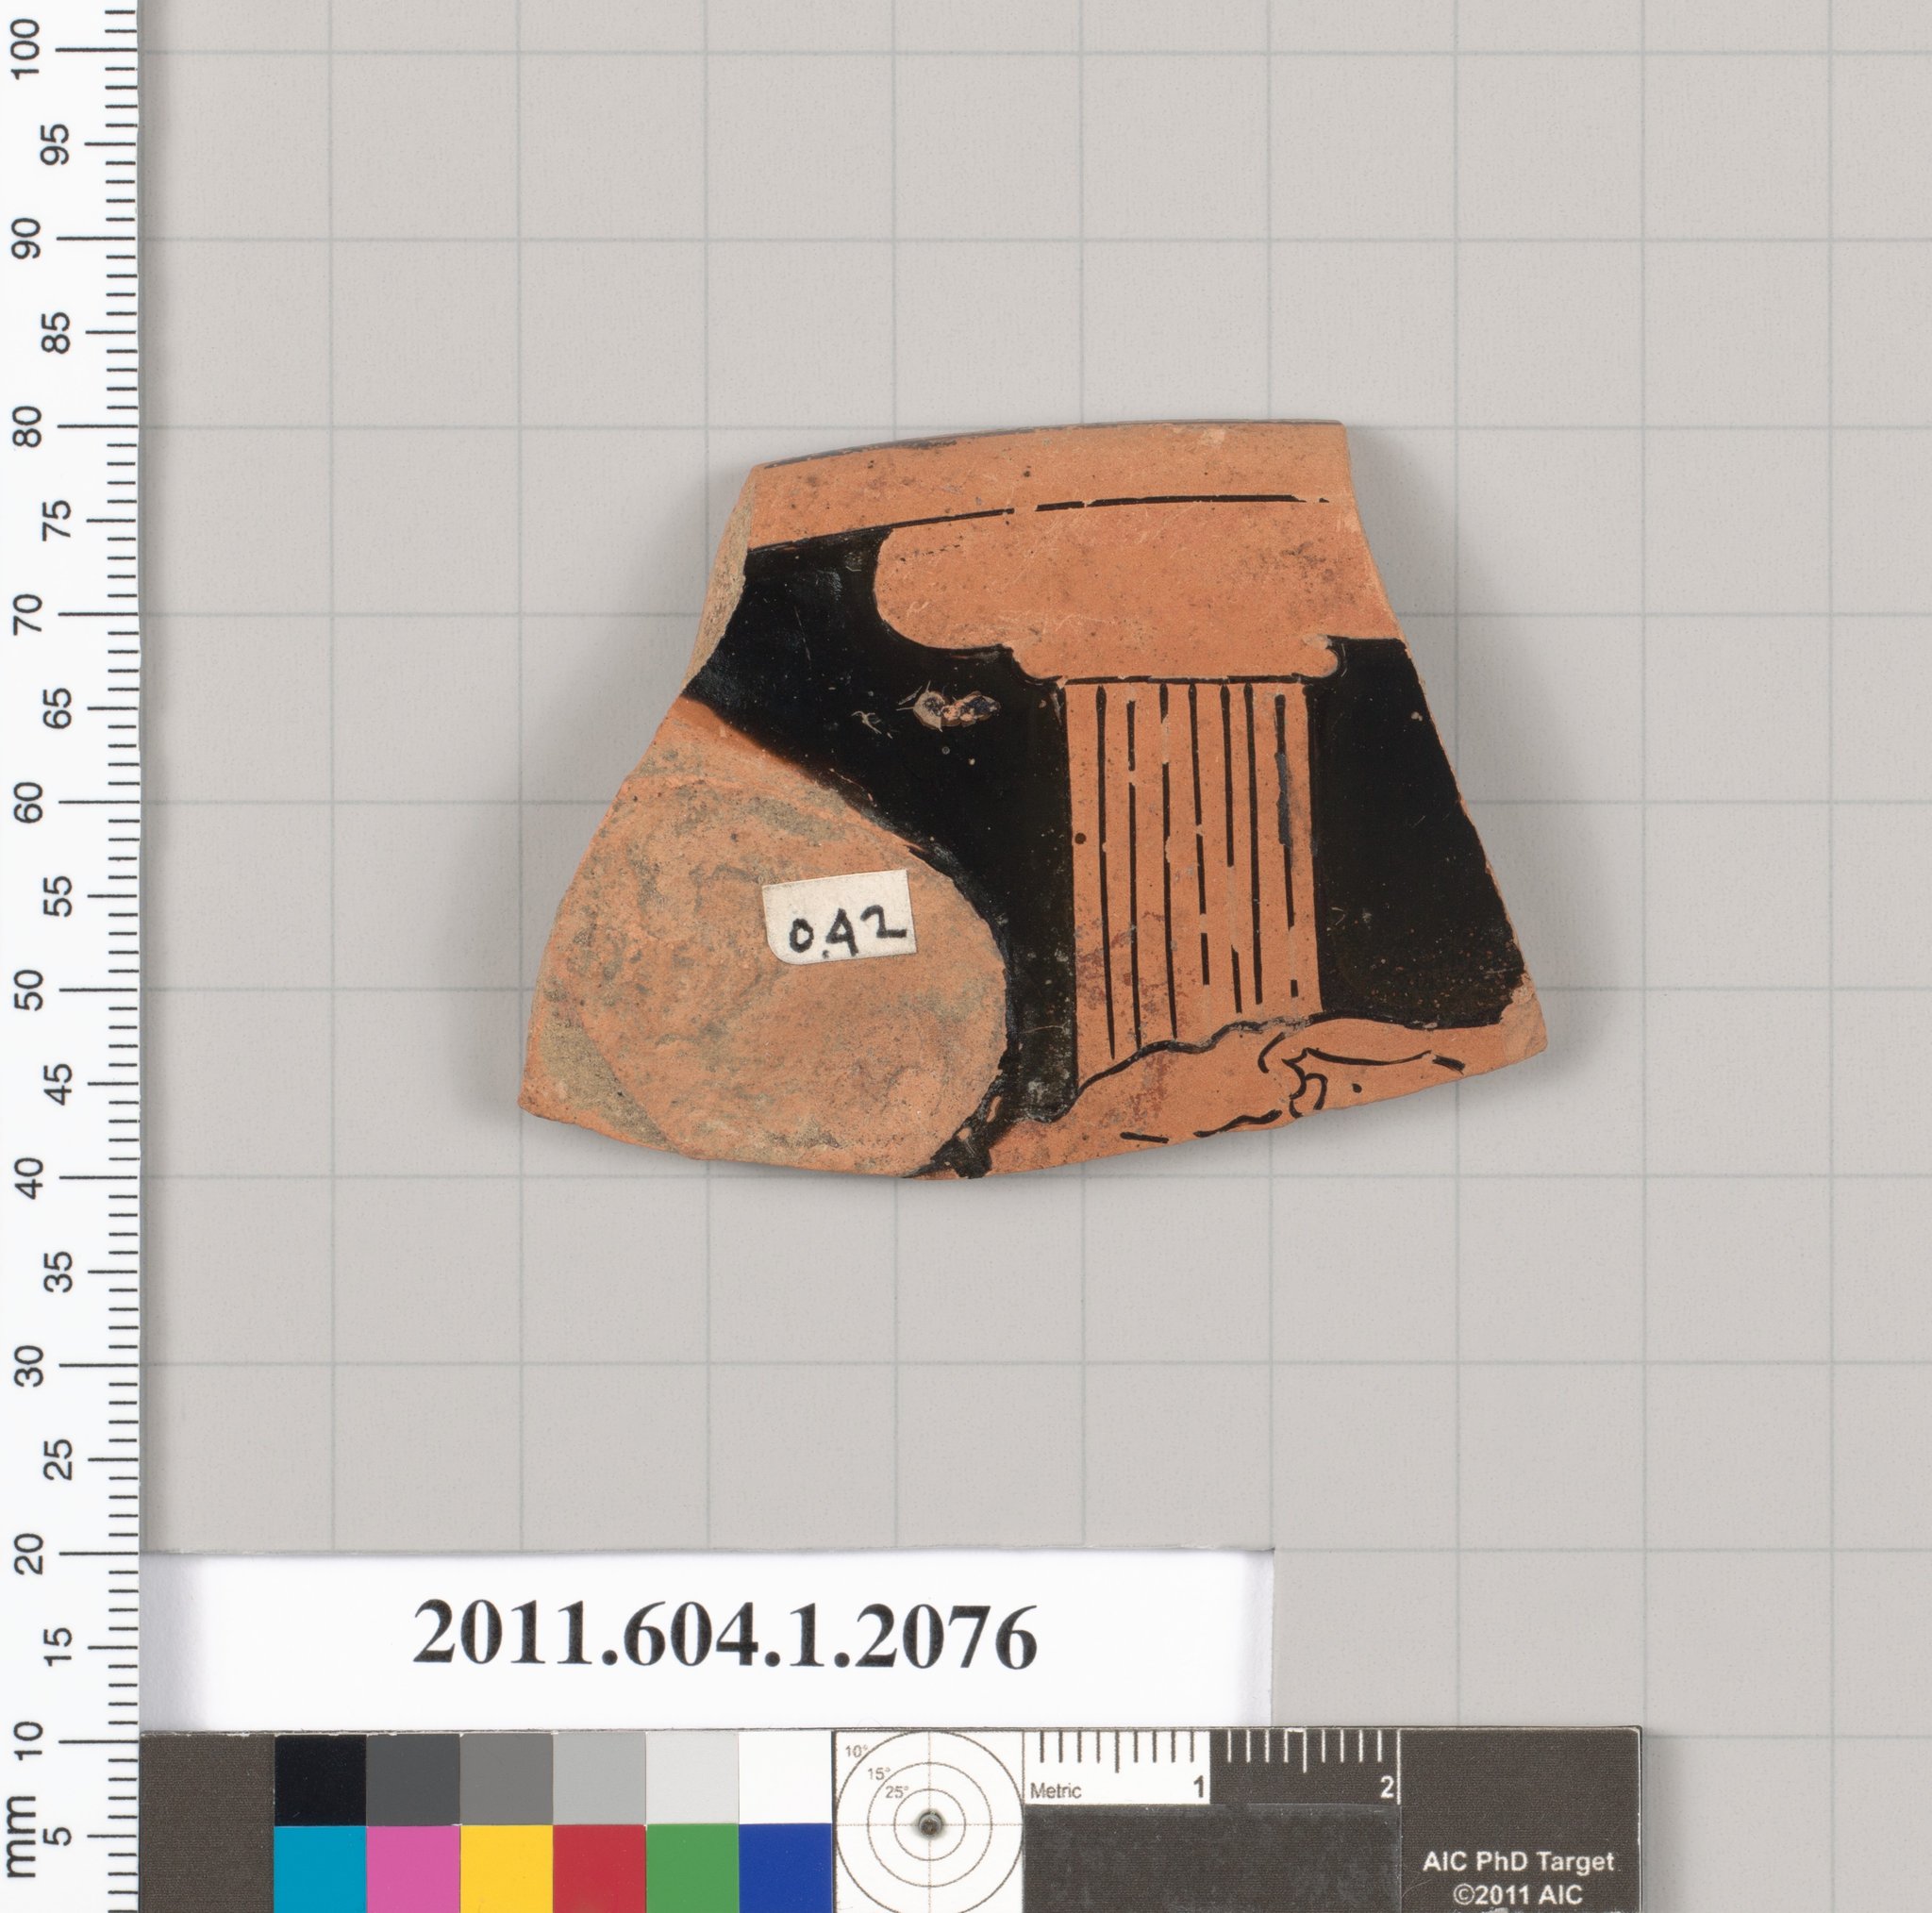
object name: kylix fragment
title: Terracotta rim fragment of a kylix (drinking cup)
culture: greek, attic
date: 475-451 BCE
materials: terracotta